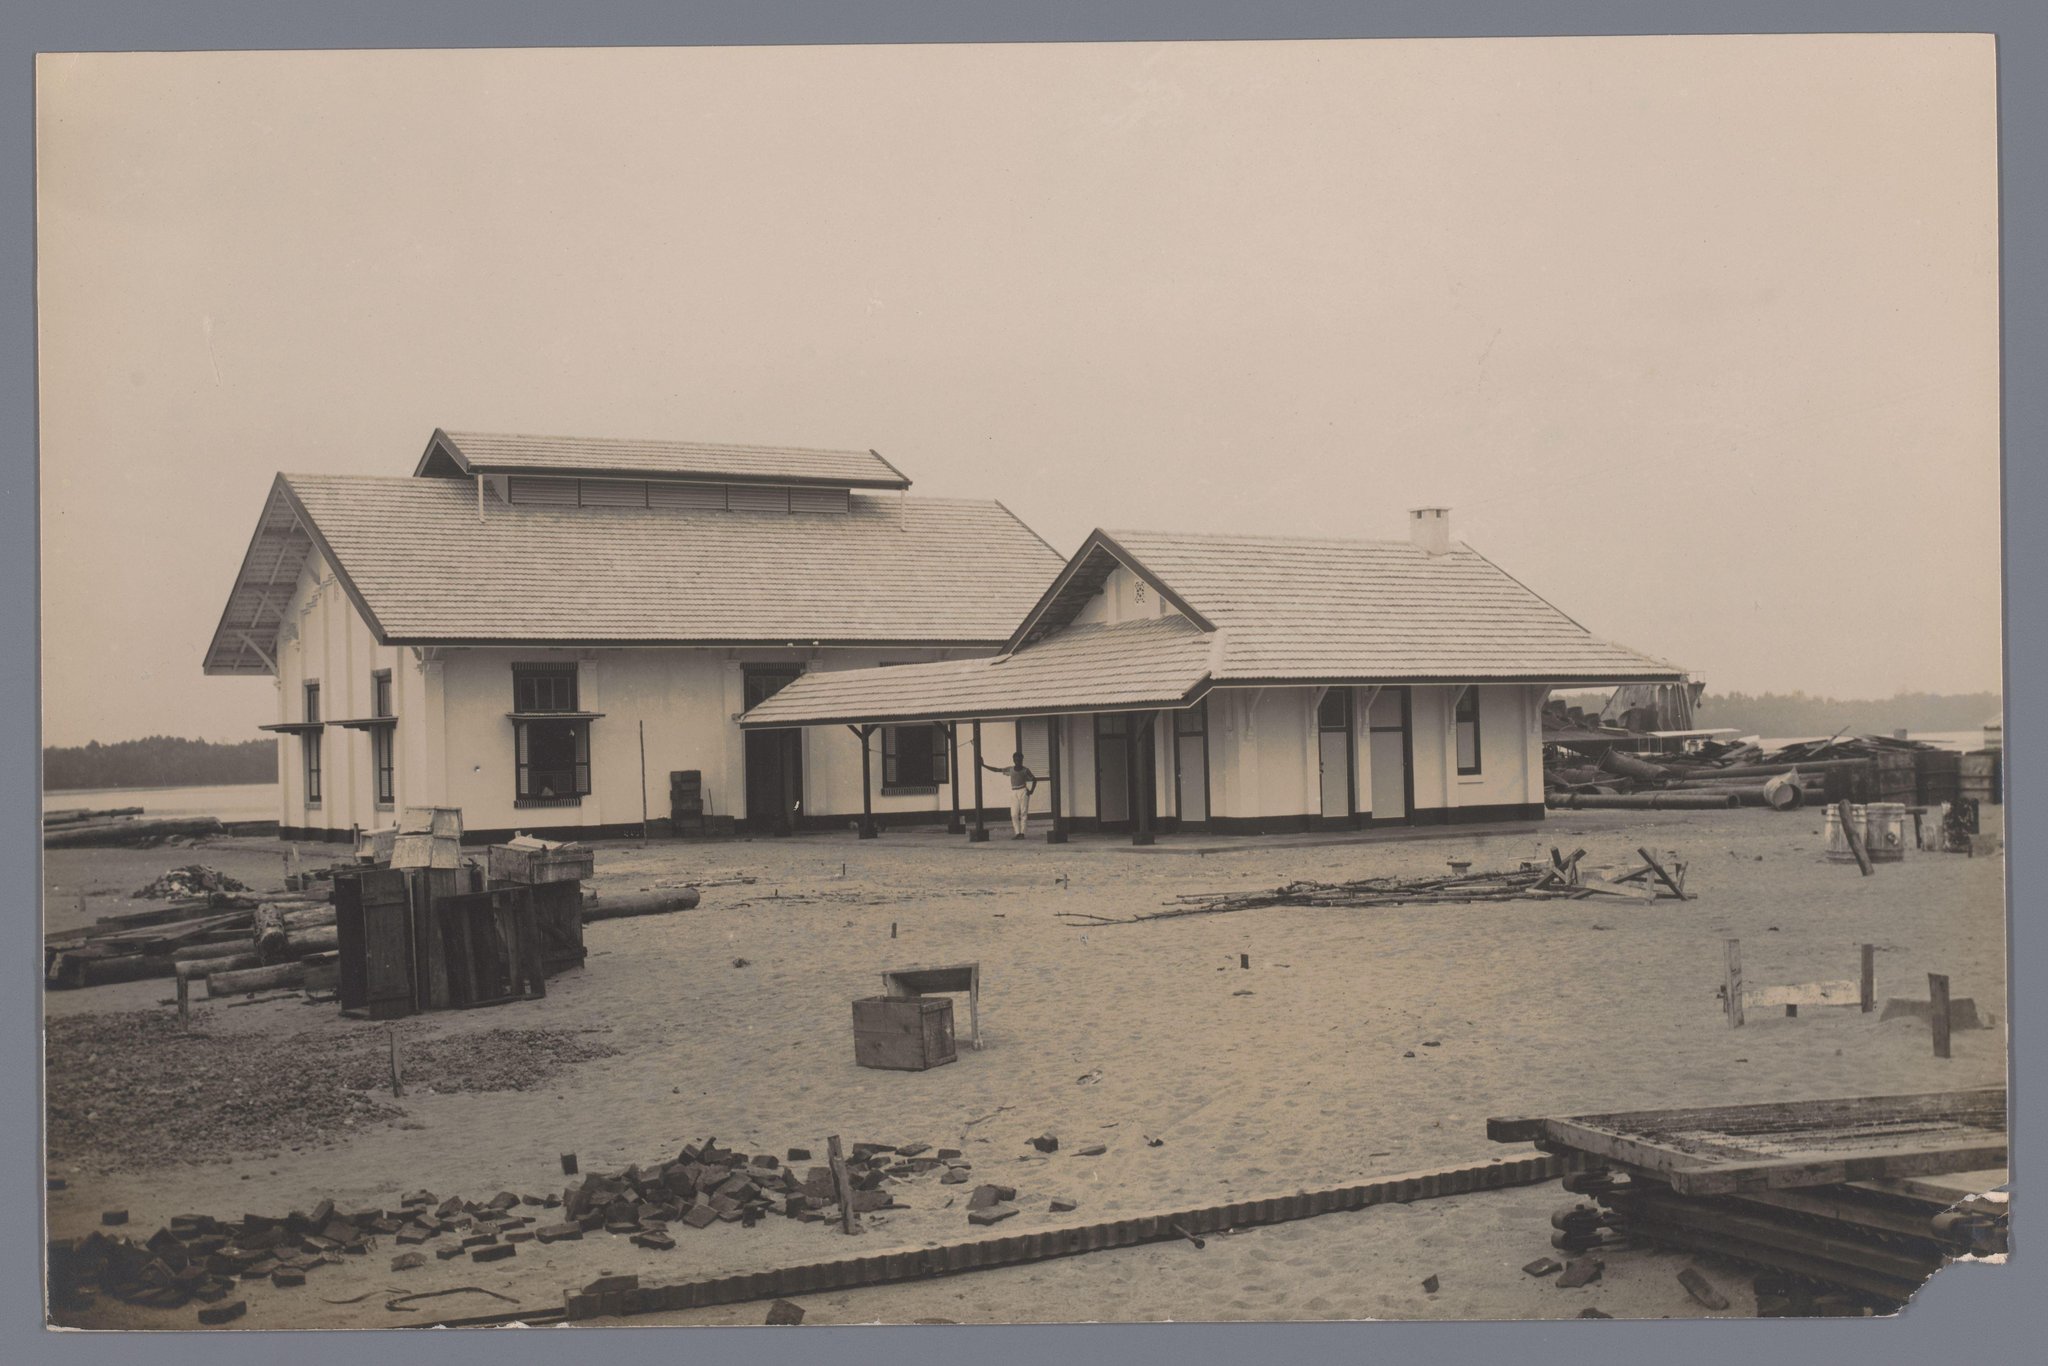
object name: photograph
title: Woonhuis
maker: karl josef john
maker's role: fotograaf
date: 1921-1922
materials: photographic support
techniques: gelatin silver print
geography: medan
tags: villa, building-site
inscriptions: workshop stamp: ‘K.J. John / Atelier voor Photographie / Medan Kesawan’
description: Woonhuis waarvan de bouw net is voltooid. Onderdeel van de groep van losse foto's over de aanleg van de haven Belawan aan de kust voor Medan, Sumatra 1921-1922.